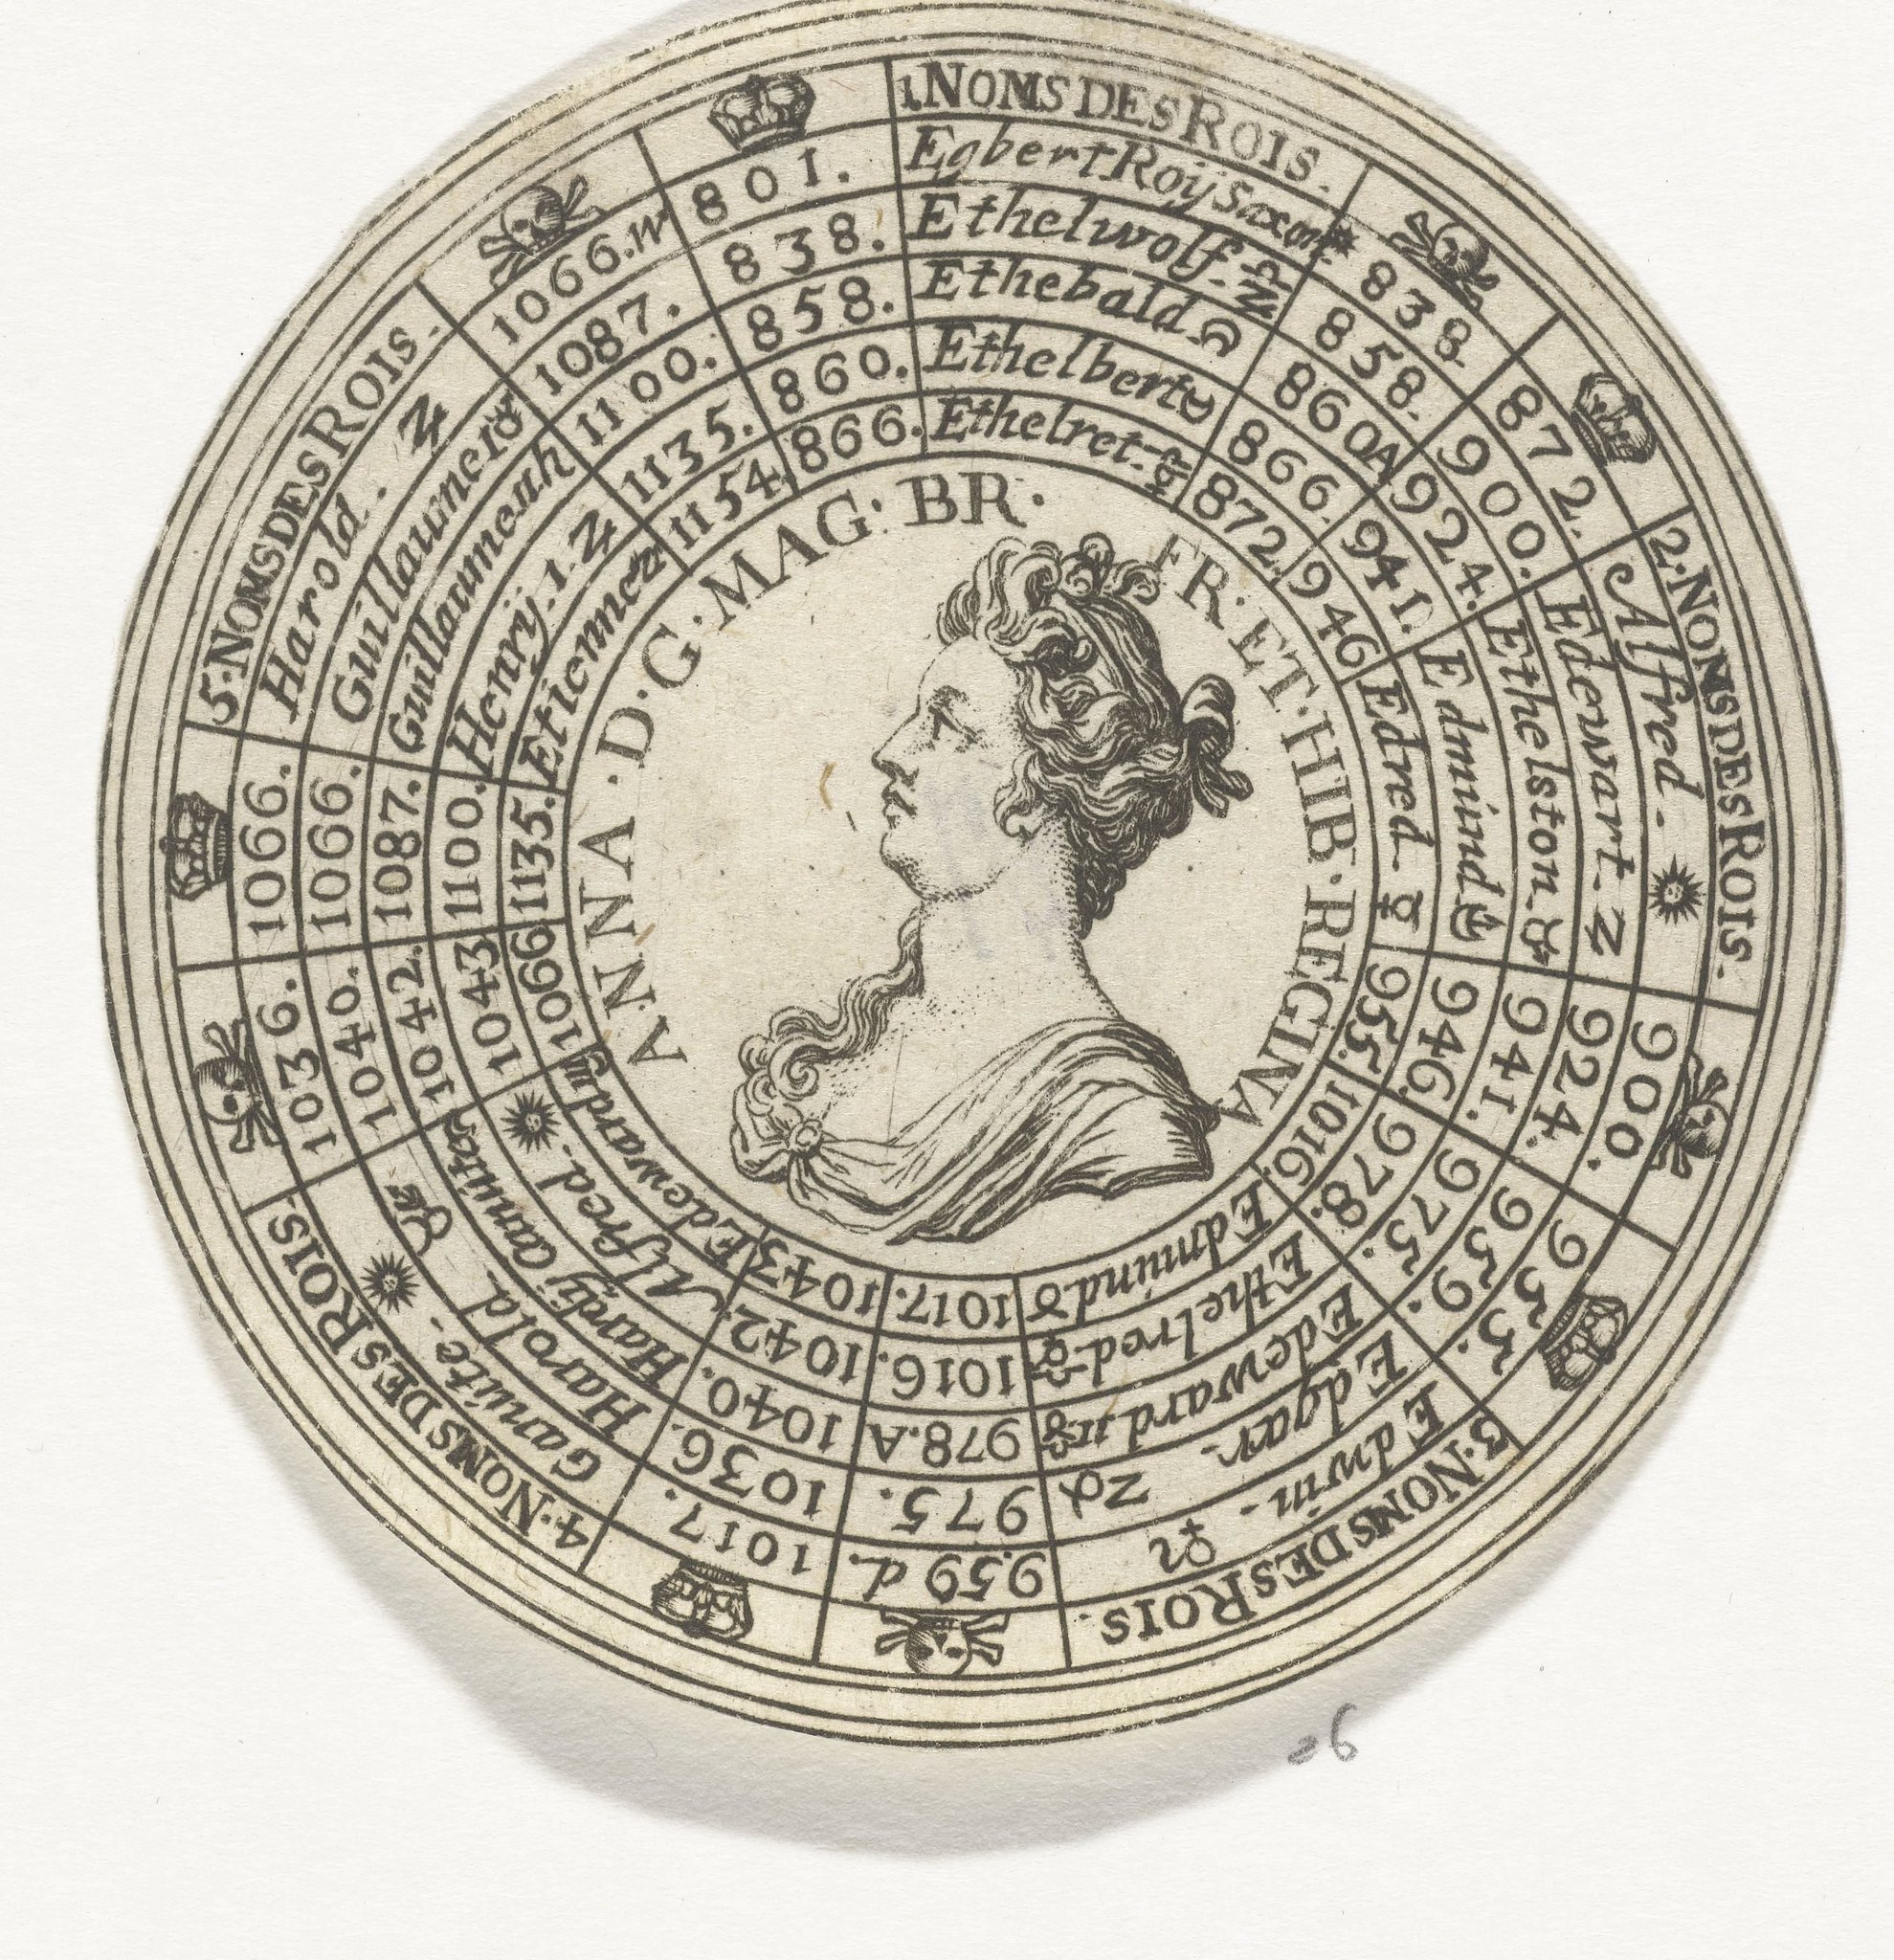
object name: print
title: Penning met het portret van koningin Anna Stuart en de namen van Engelse koningen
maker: Anonymous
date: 1702-1714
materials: paper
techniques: etching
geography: amsterdam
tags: london, anna stuart (koningin van engeland en schotland), king, seal (symbol of sovereignty)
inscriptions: number: ‘27’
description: Ontwerp van een ronde penning met, in zes concentrische cirkels, de namen van Engelse koningen en hun regeringsjaren, beginnende bij koning Egbert van Wessex en eindigend bij koning Stefanus. In het midden van de penning het portret van koningin Anna Stuart.